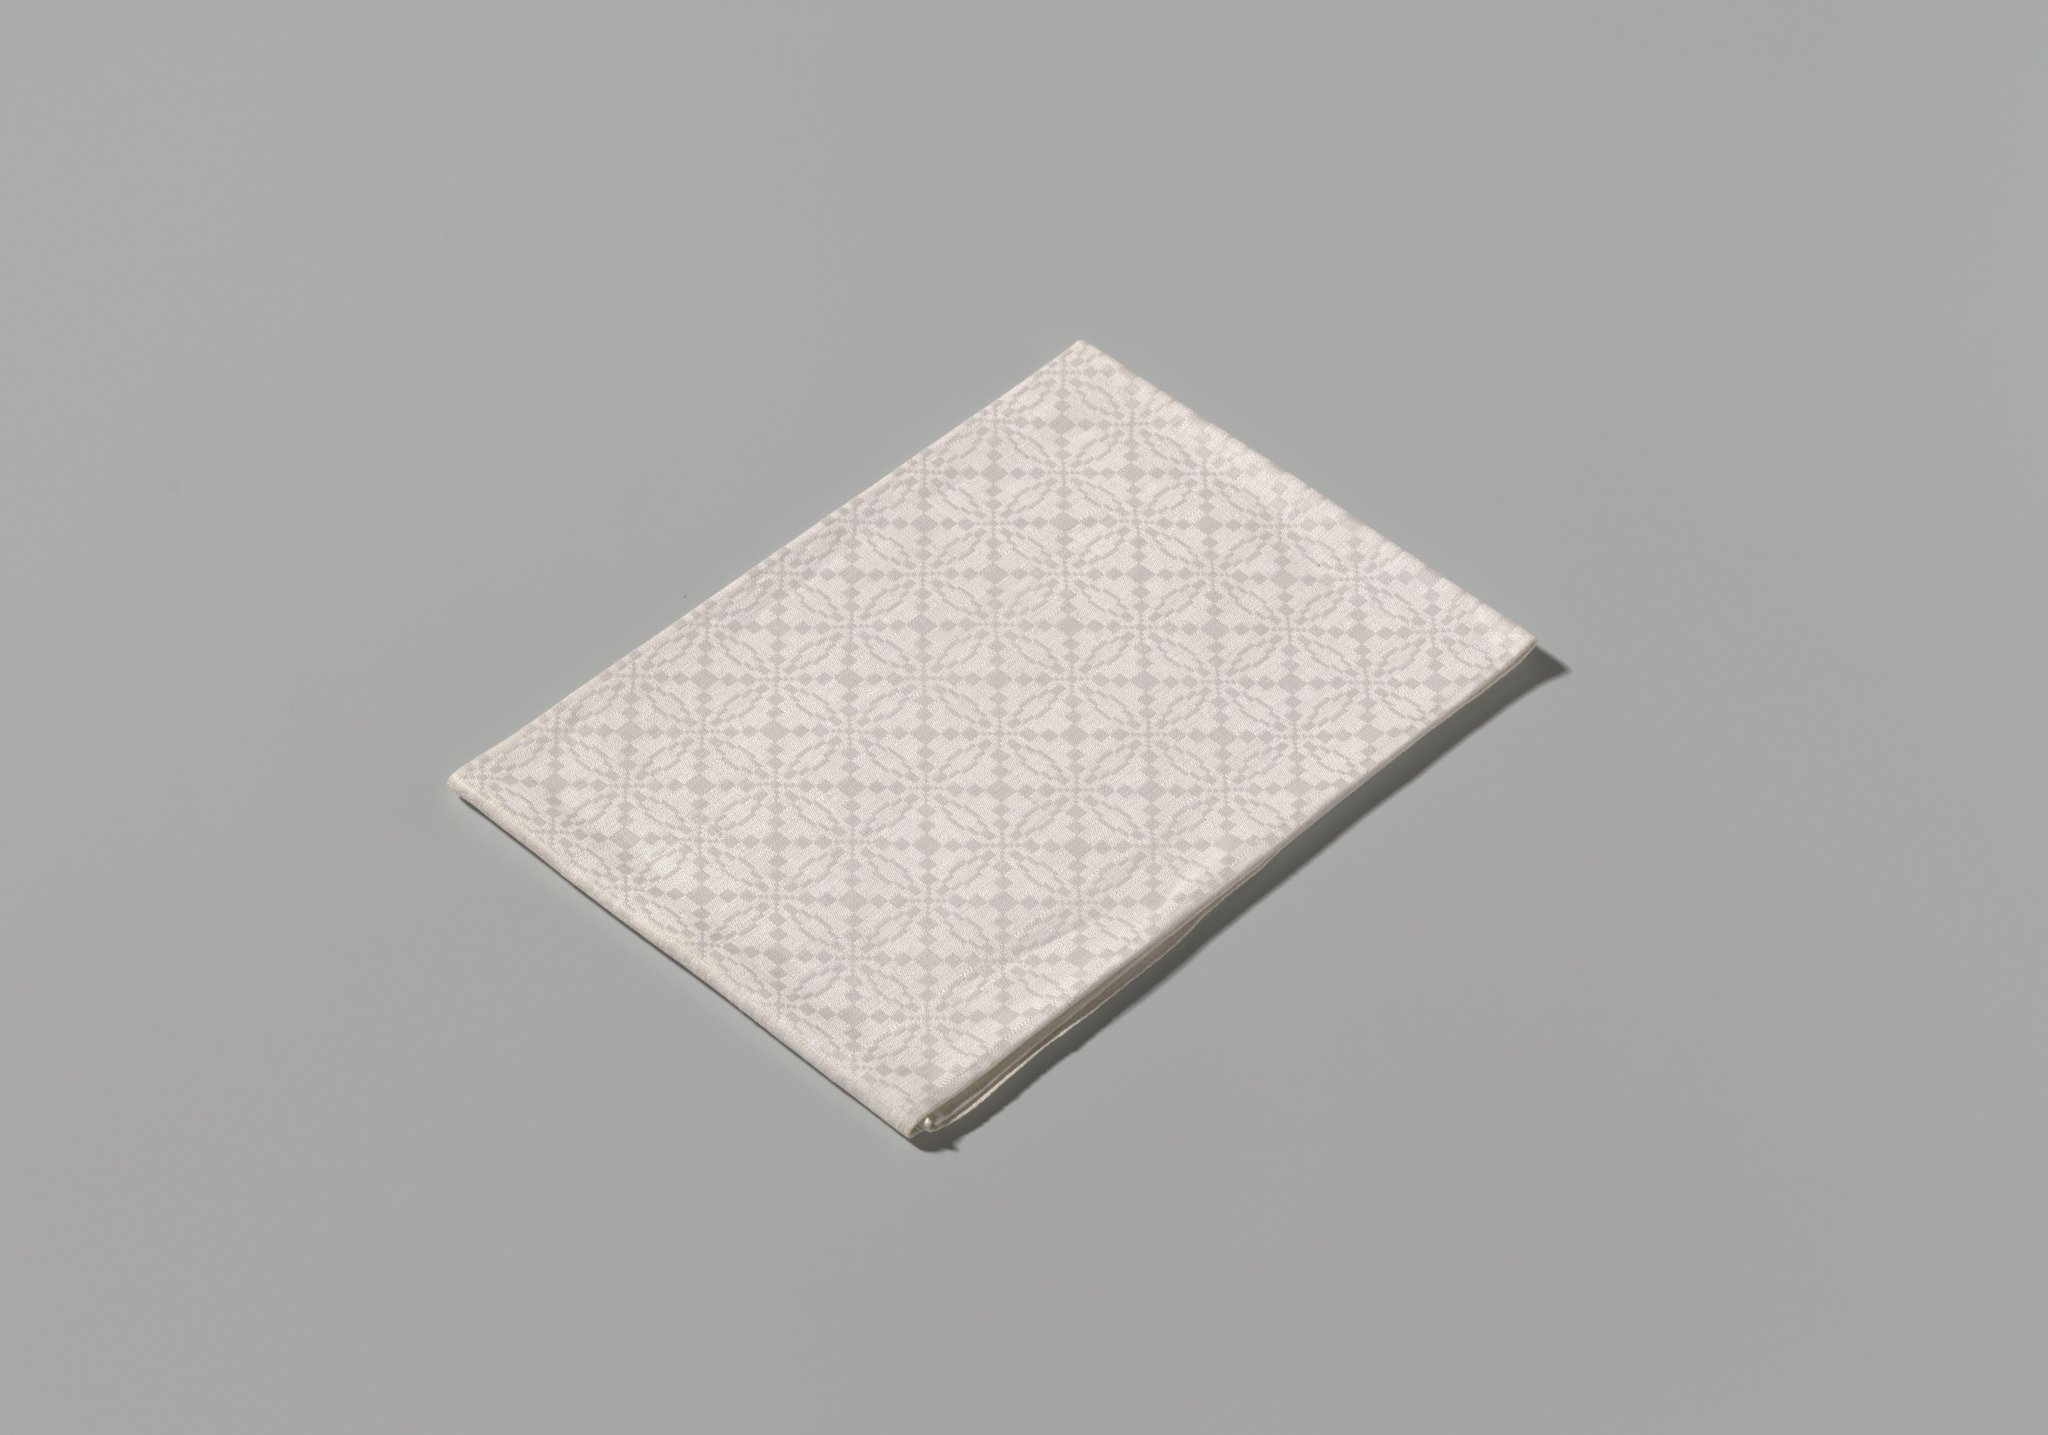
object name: napkin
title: Wit linnen pellen servet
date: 1600-1650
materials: linen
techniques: peeled fabric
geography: northern netherlands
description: Wit linnen pellen servet, gemerkt WO 70.